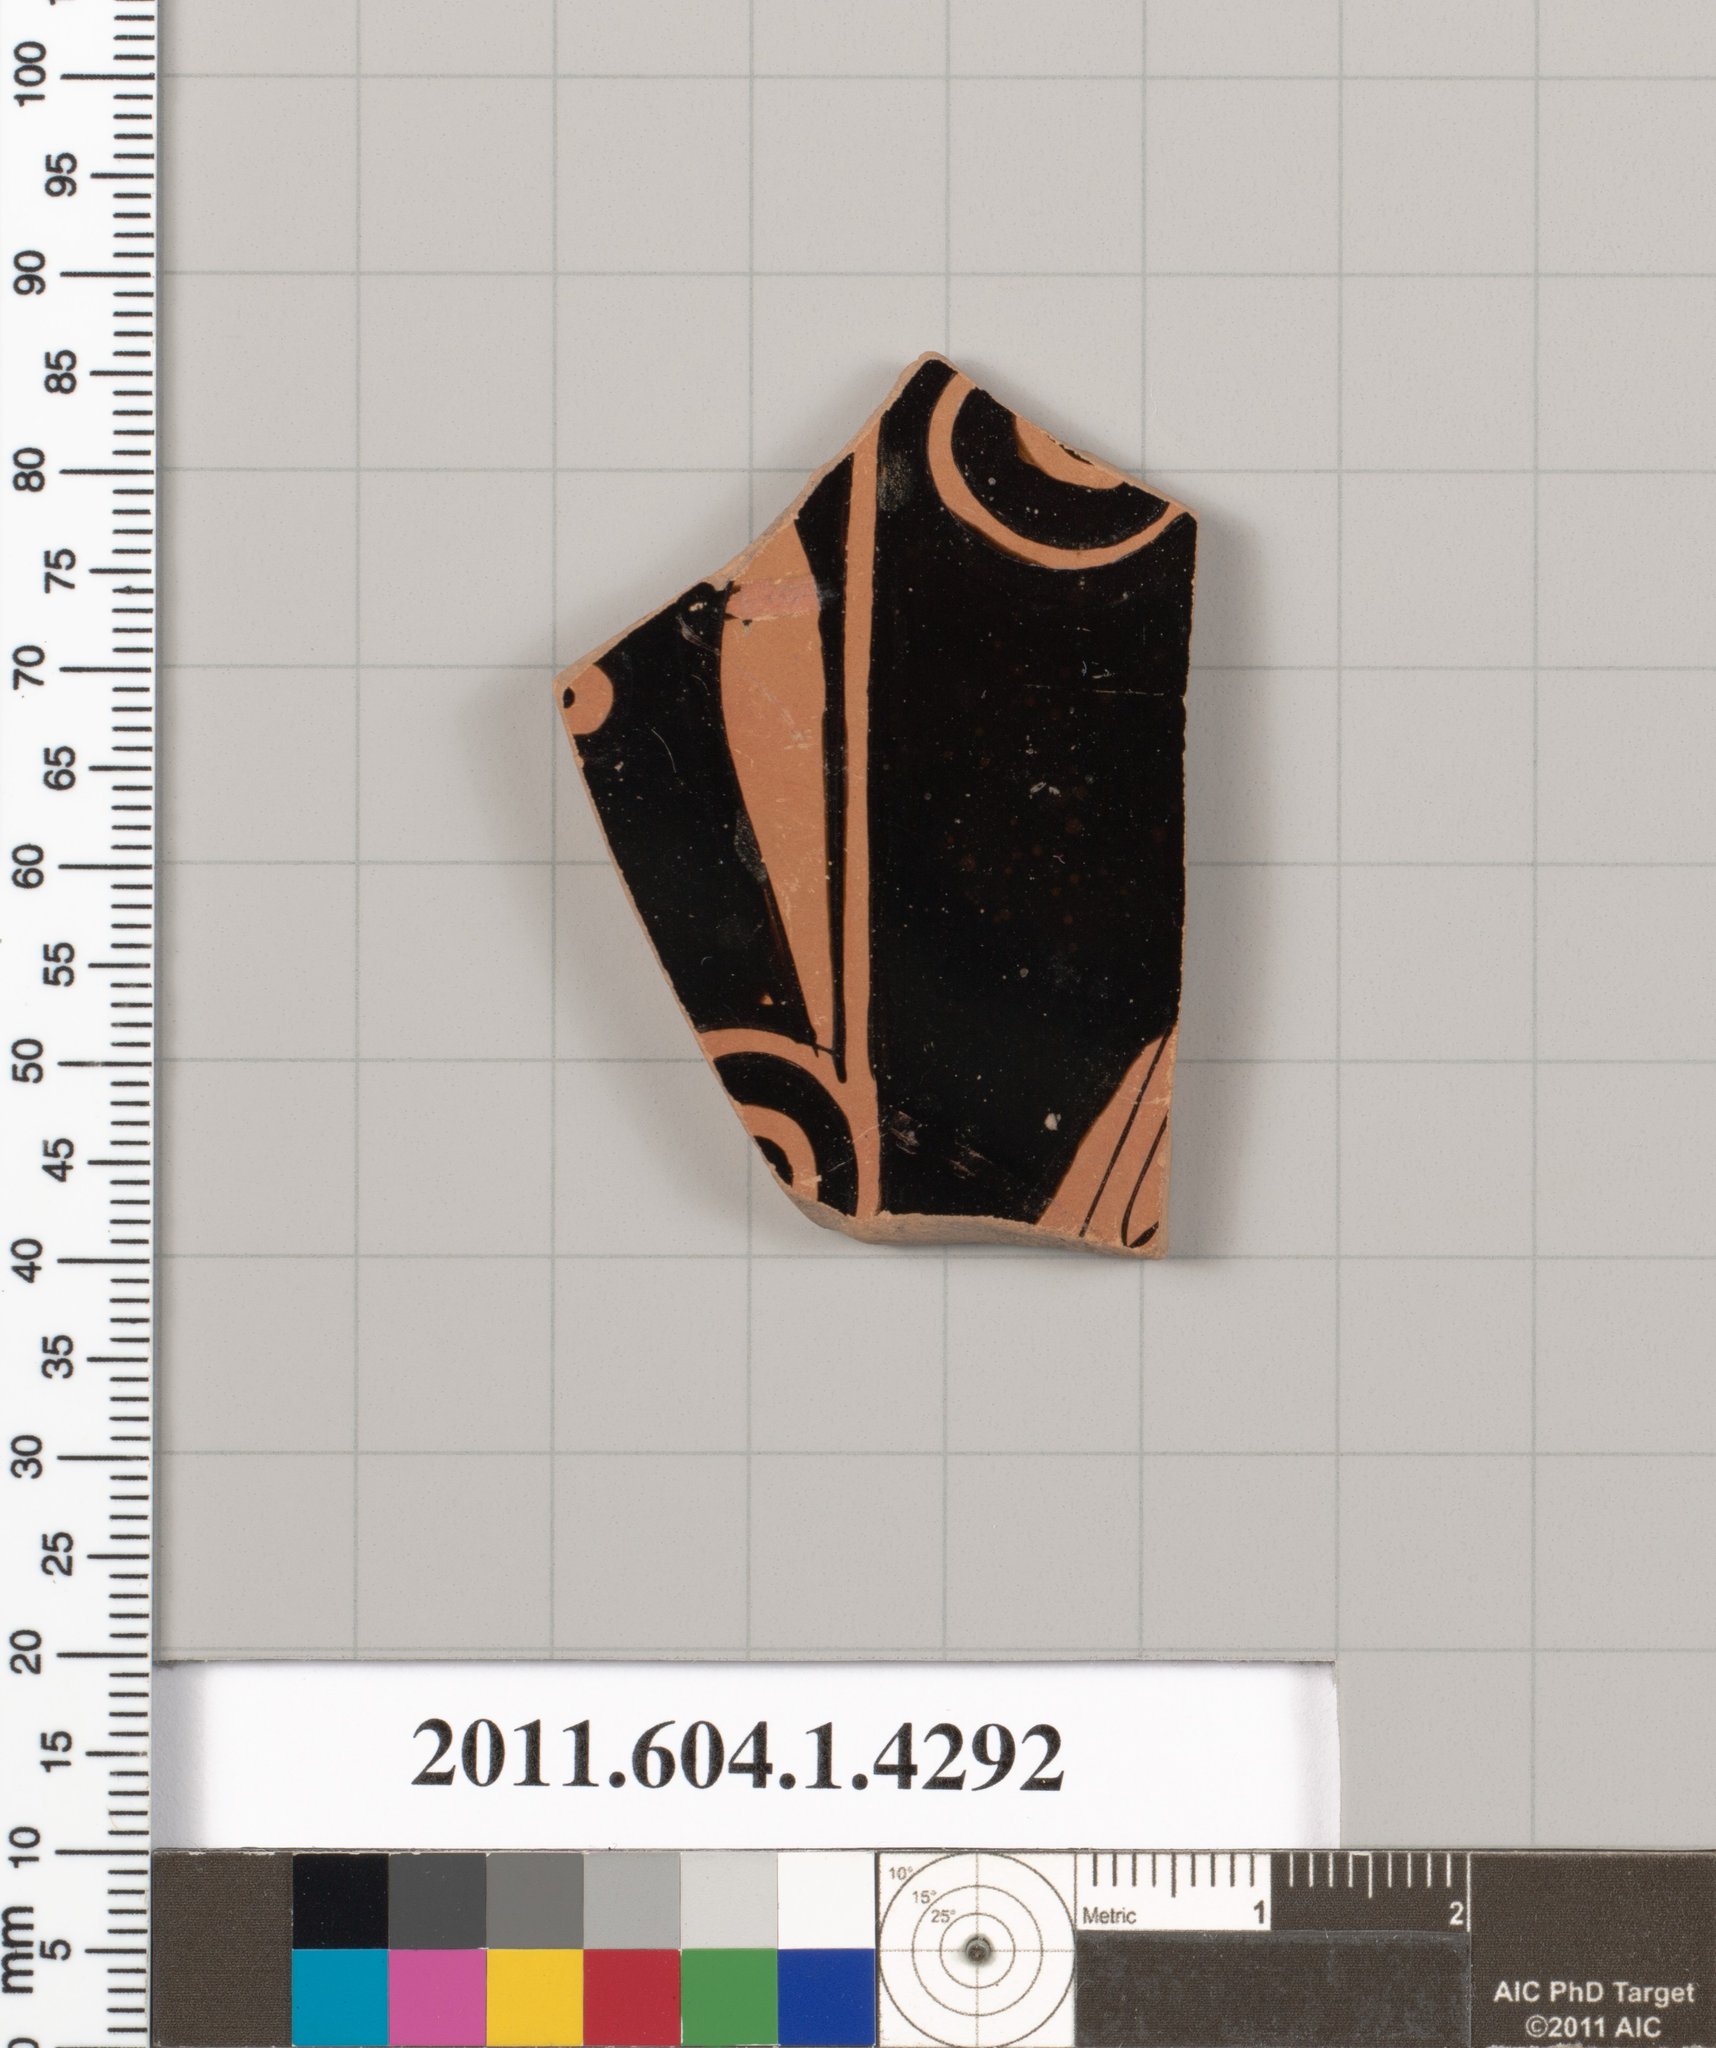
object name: kylix fragment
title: Terracotta fragment of a kylix (drinking cup)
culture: greek, attic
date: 475-451 BCE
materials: terracotta